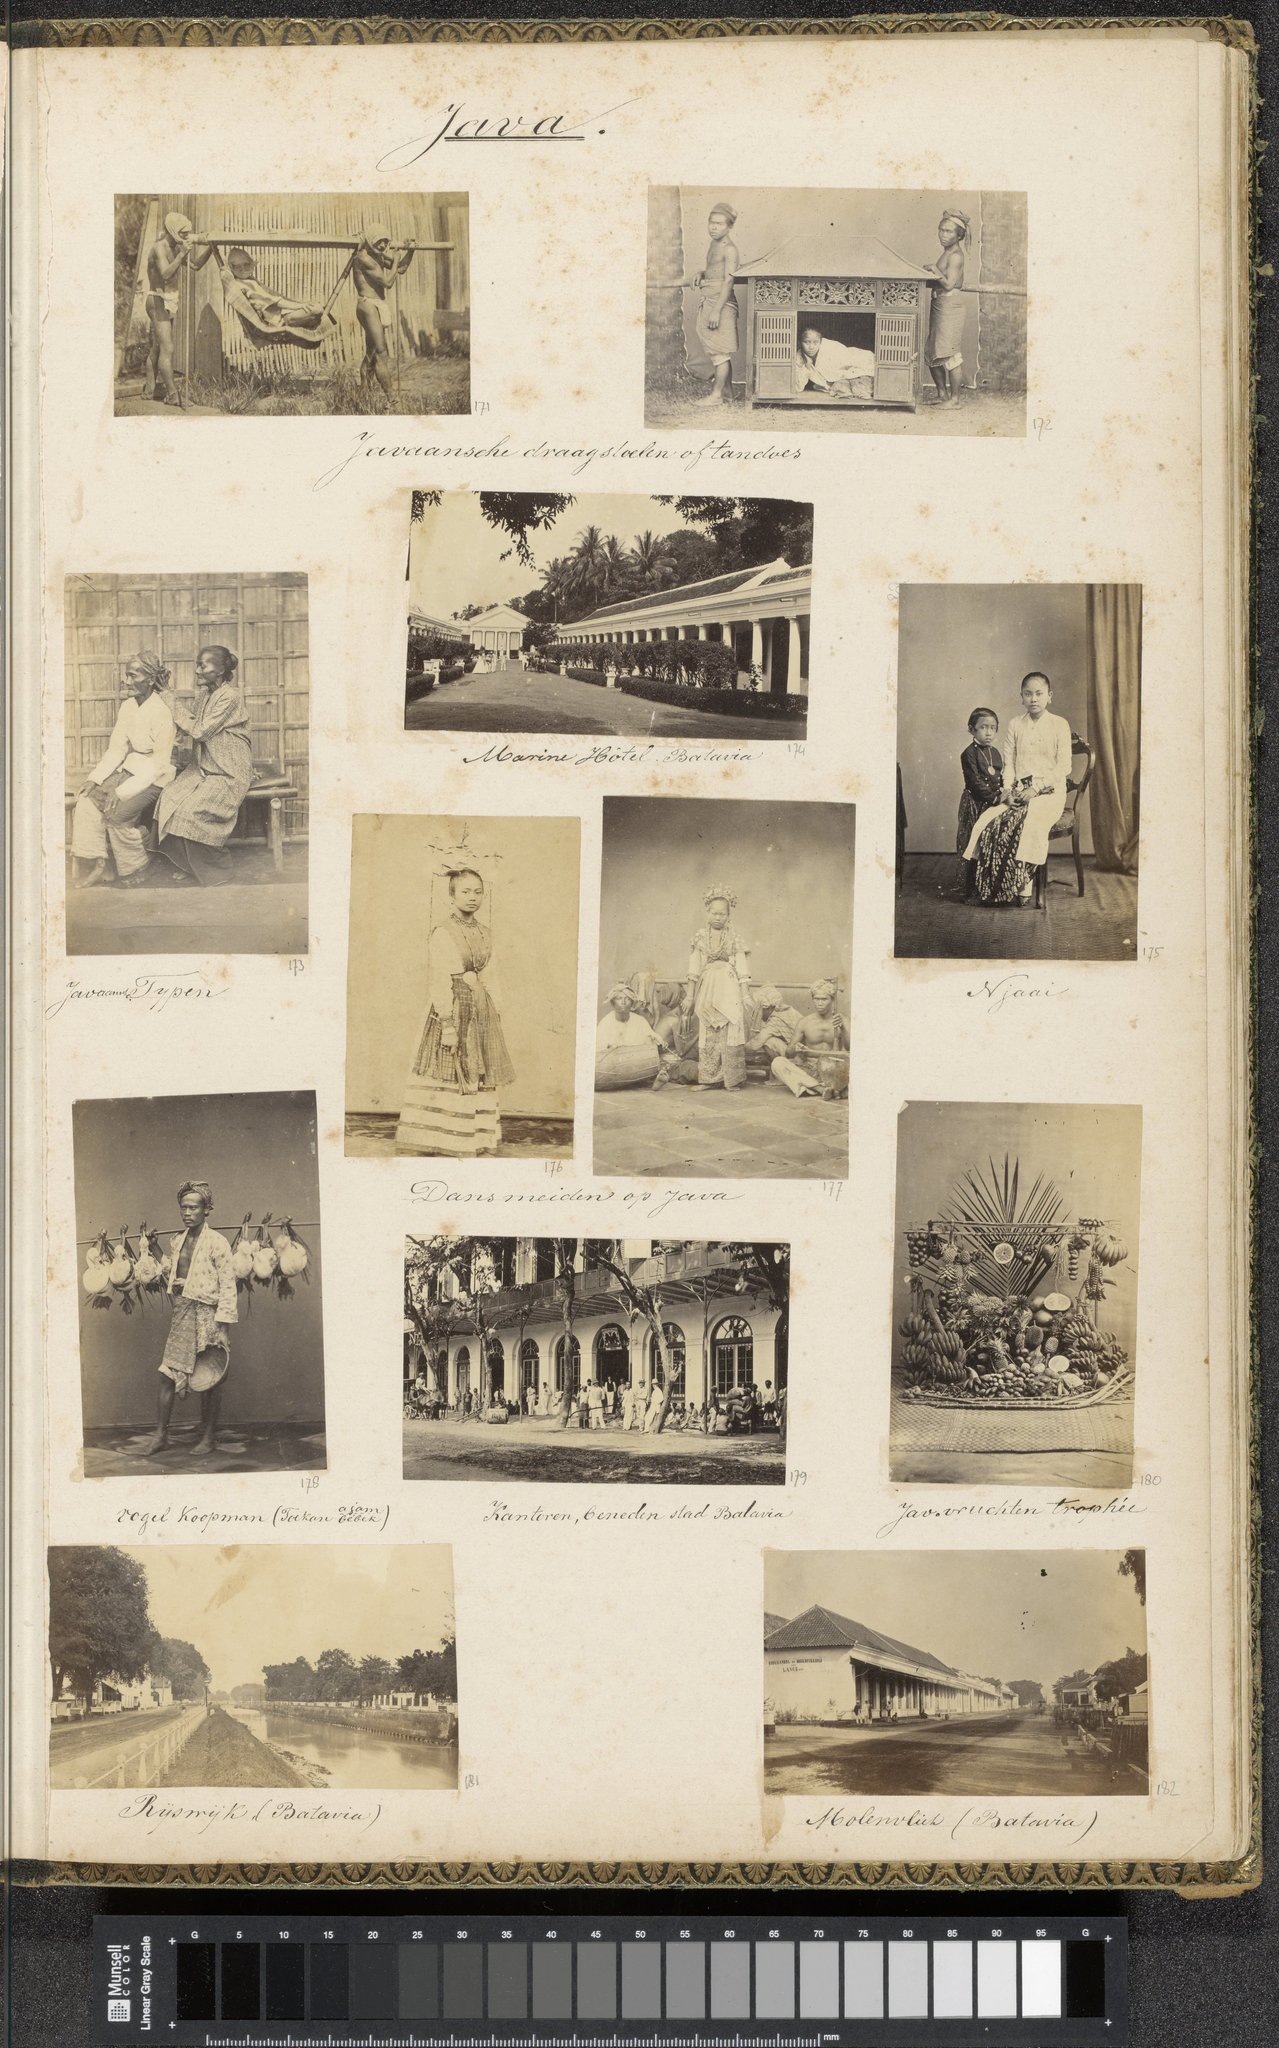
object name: album leaf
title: Dragers met een persoon in een draagstoel op Java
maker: Anonymous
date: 1870-1880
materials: paper, photographic support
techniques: albumen print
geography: java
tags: (carrying a person in a) sedan-chair, java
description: Onderdeel van Fotoalbum van Robert Daniel Crommelin (1841-1907).